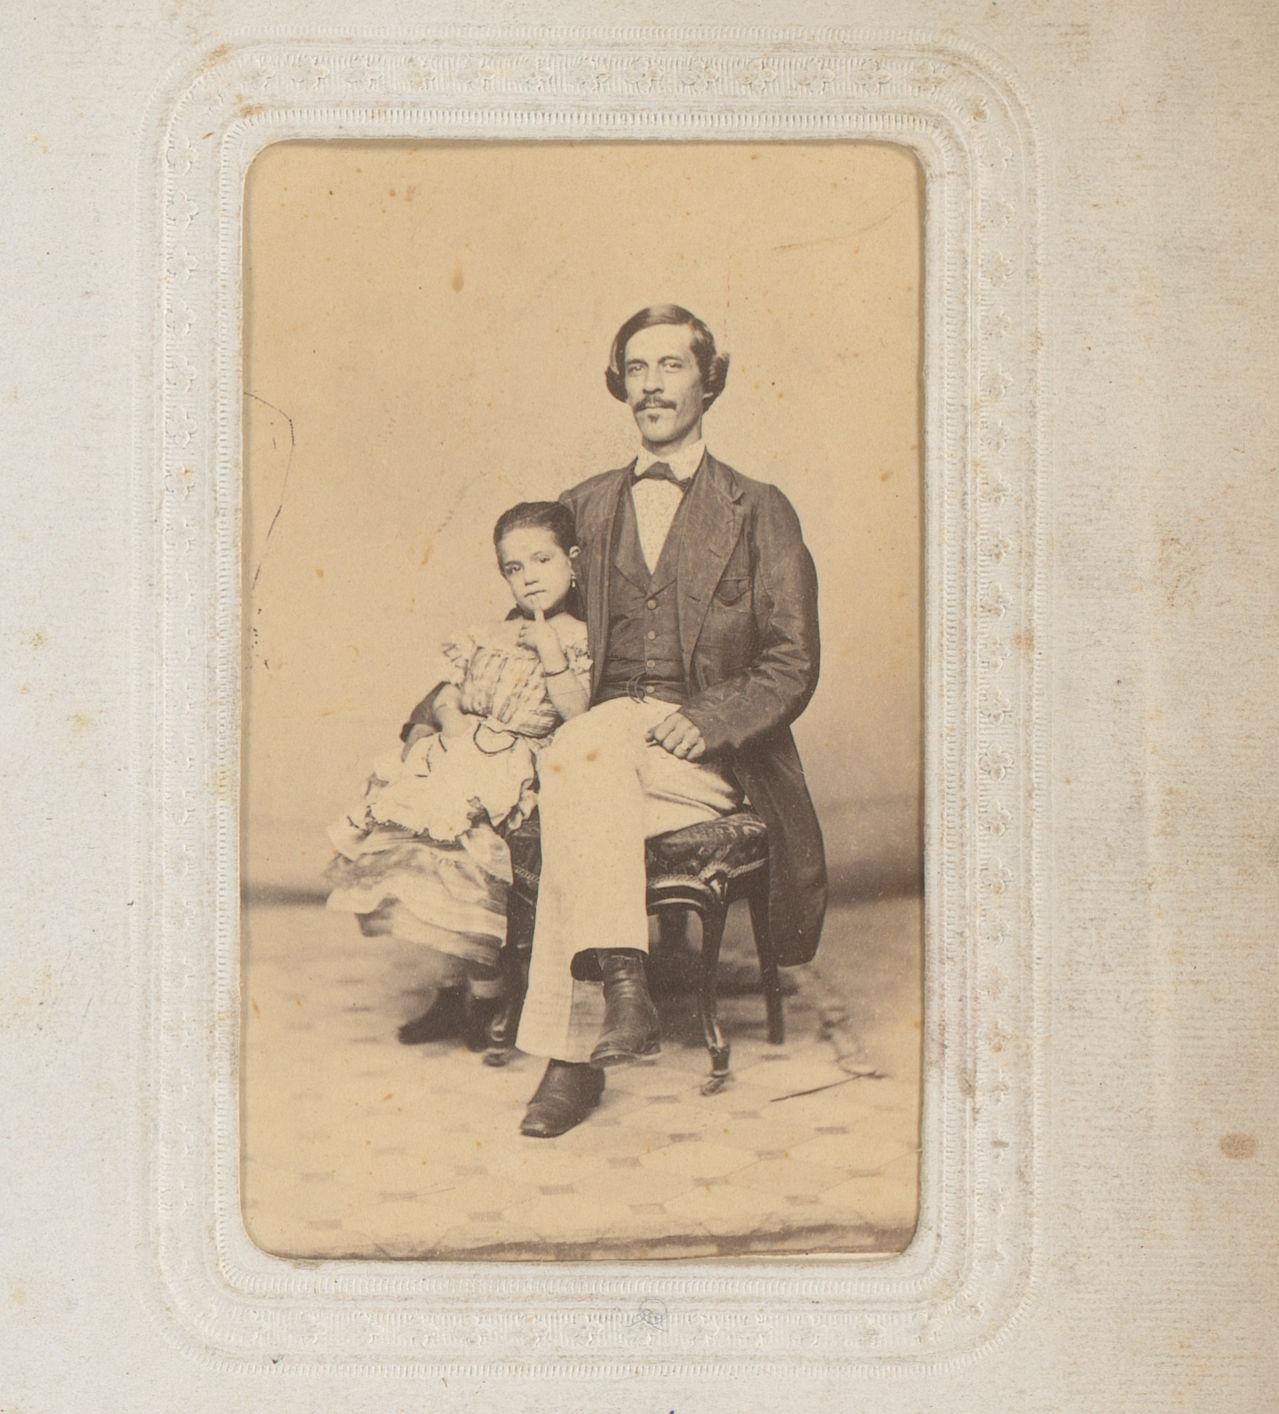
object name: album leaf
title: Portret van een vader met dochter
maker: Anonymous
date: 1860-1890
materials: cardboard, photographic support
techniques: albumen print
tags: father and daughter(s) (family group)